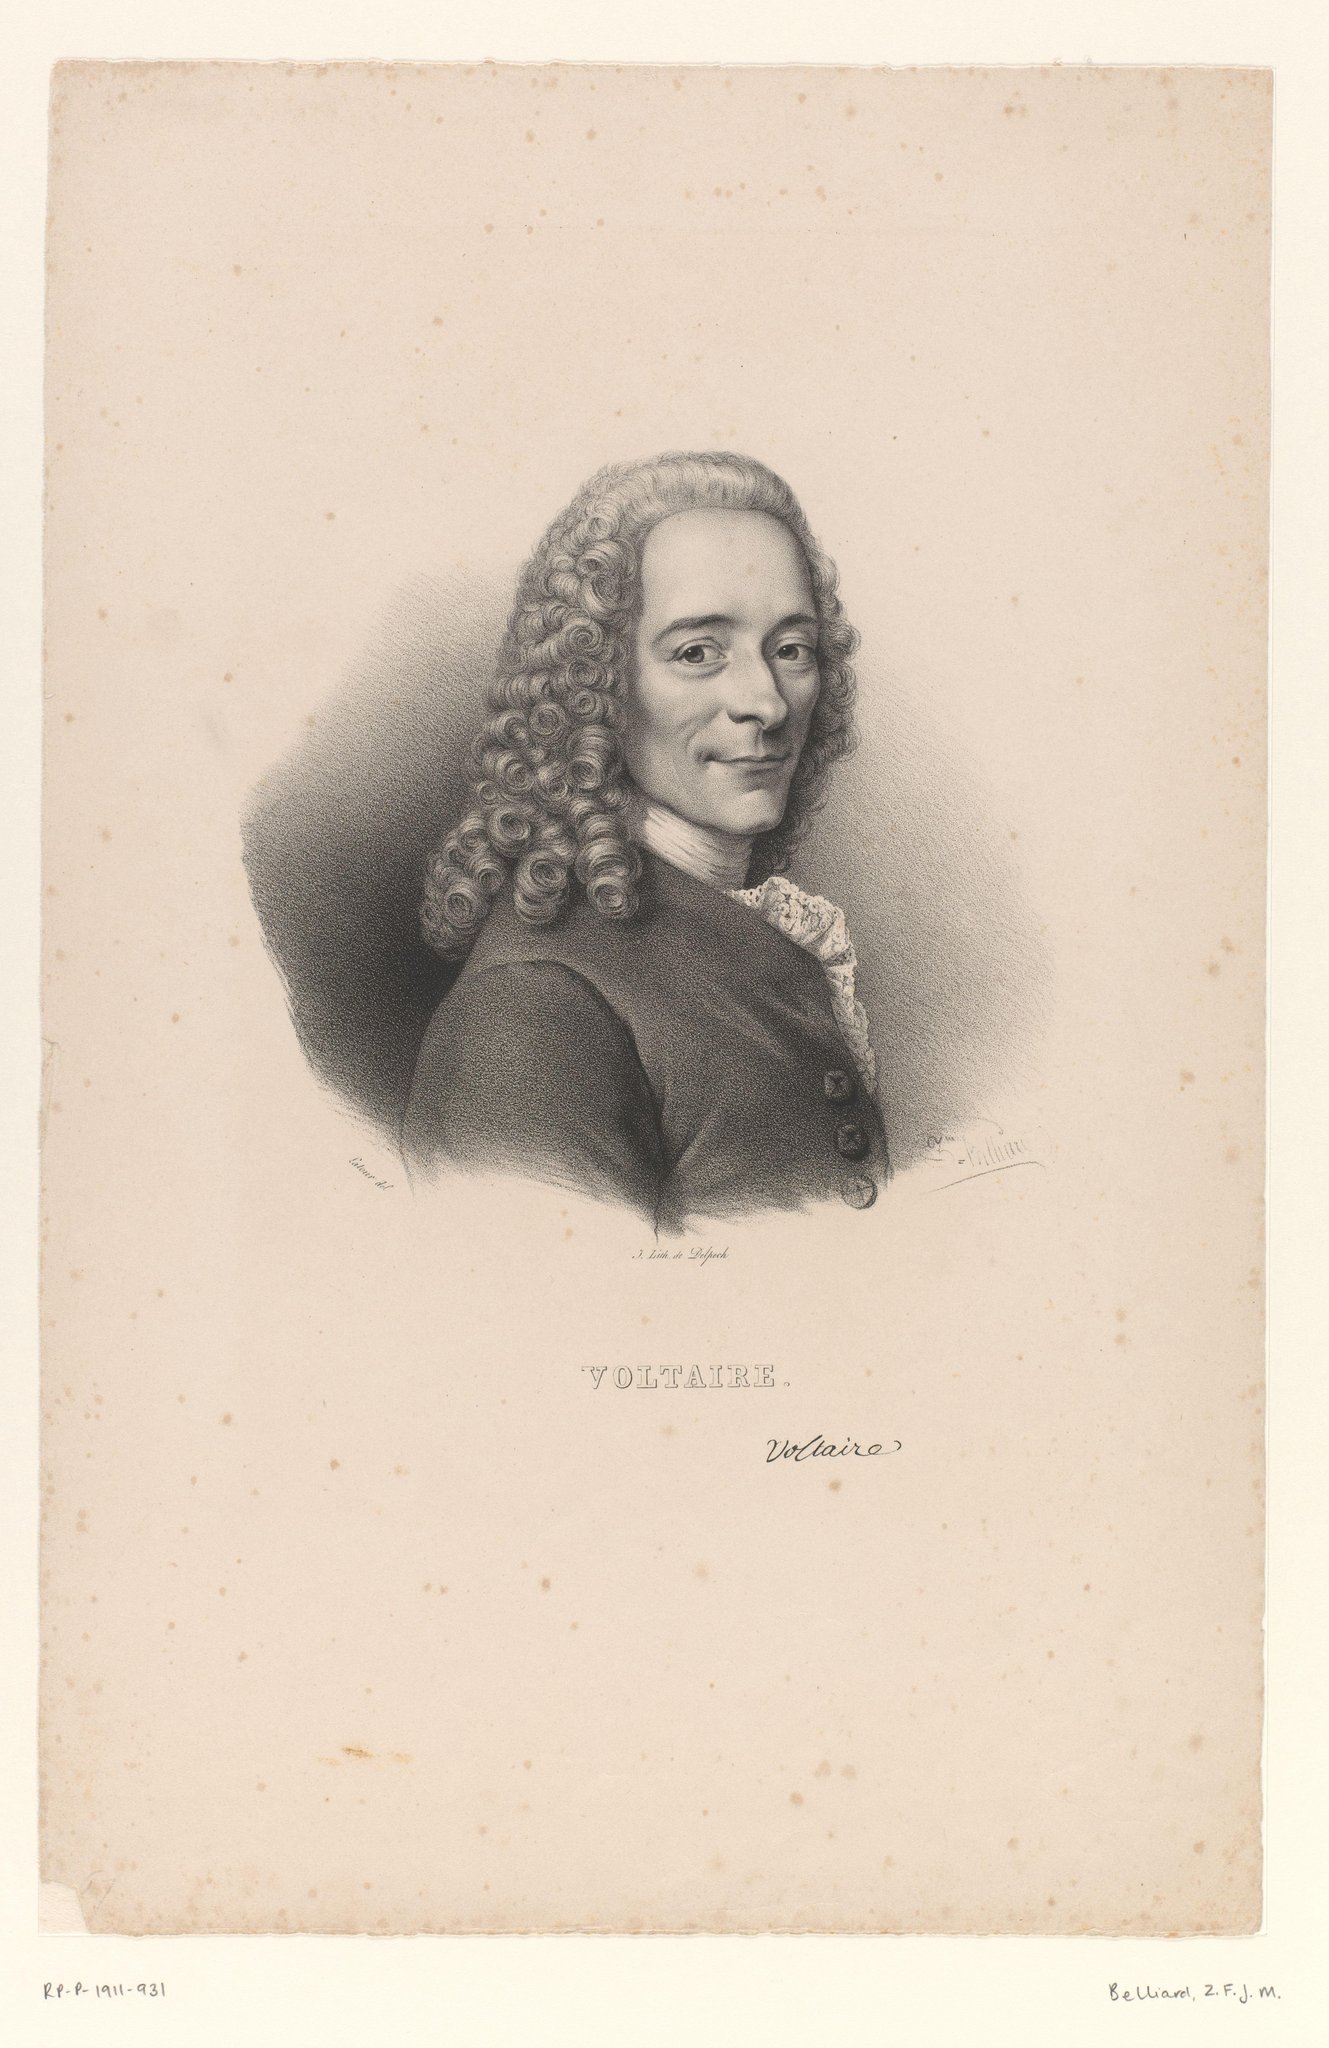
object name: book illustration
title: Portret van de schrijver en filosoof Voltaire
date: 1828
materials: paper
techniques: lithograph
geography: paris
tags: maurice-quentin de la tour, historical persons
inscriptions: collector's mark: Lugt 2228a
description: Prent gepubliceerd in: Iconographie française, ou Choix de deux cents portraits d'hommes et de femmes depuis le règne de Charles VII jusqu'à la fin de celui de Louis XVI, publié par Madame Delpech, Parijs 1840.